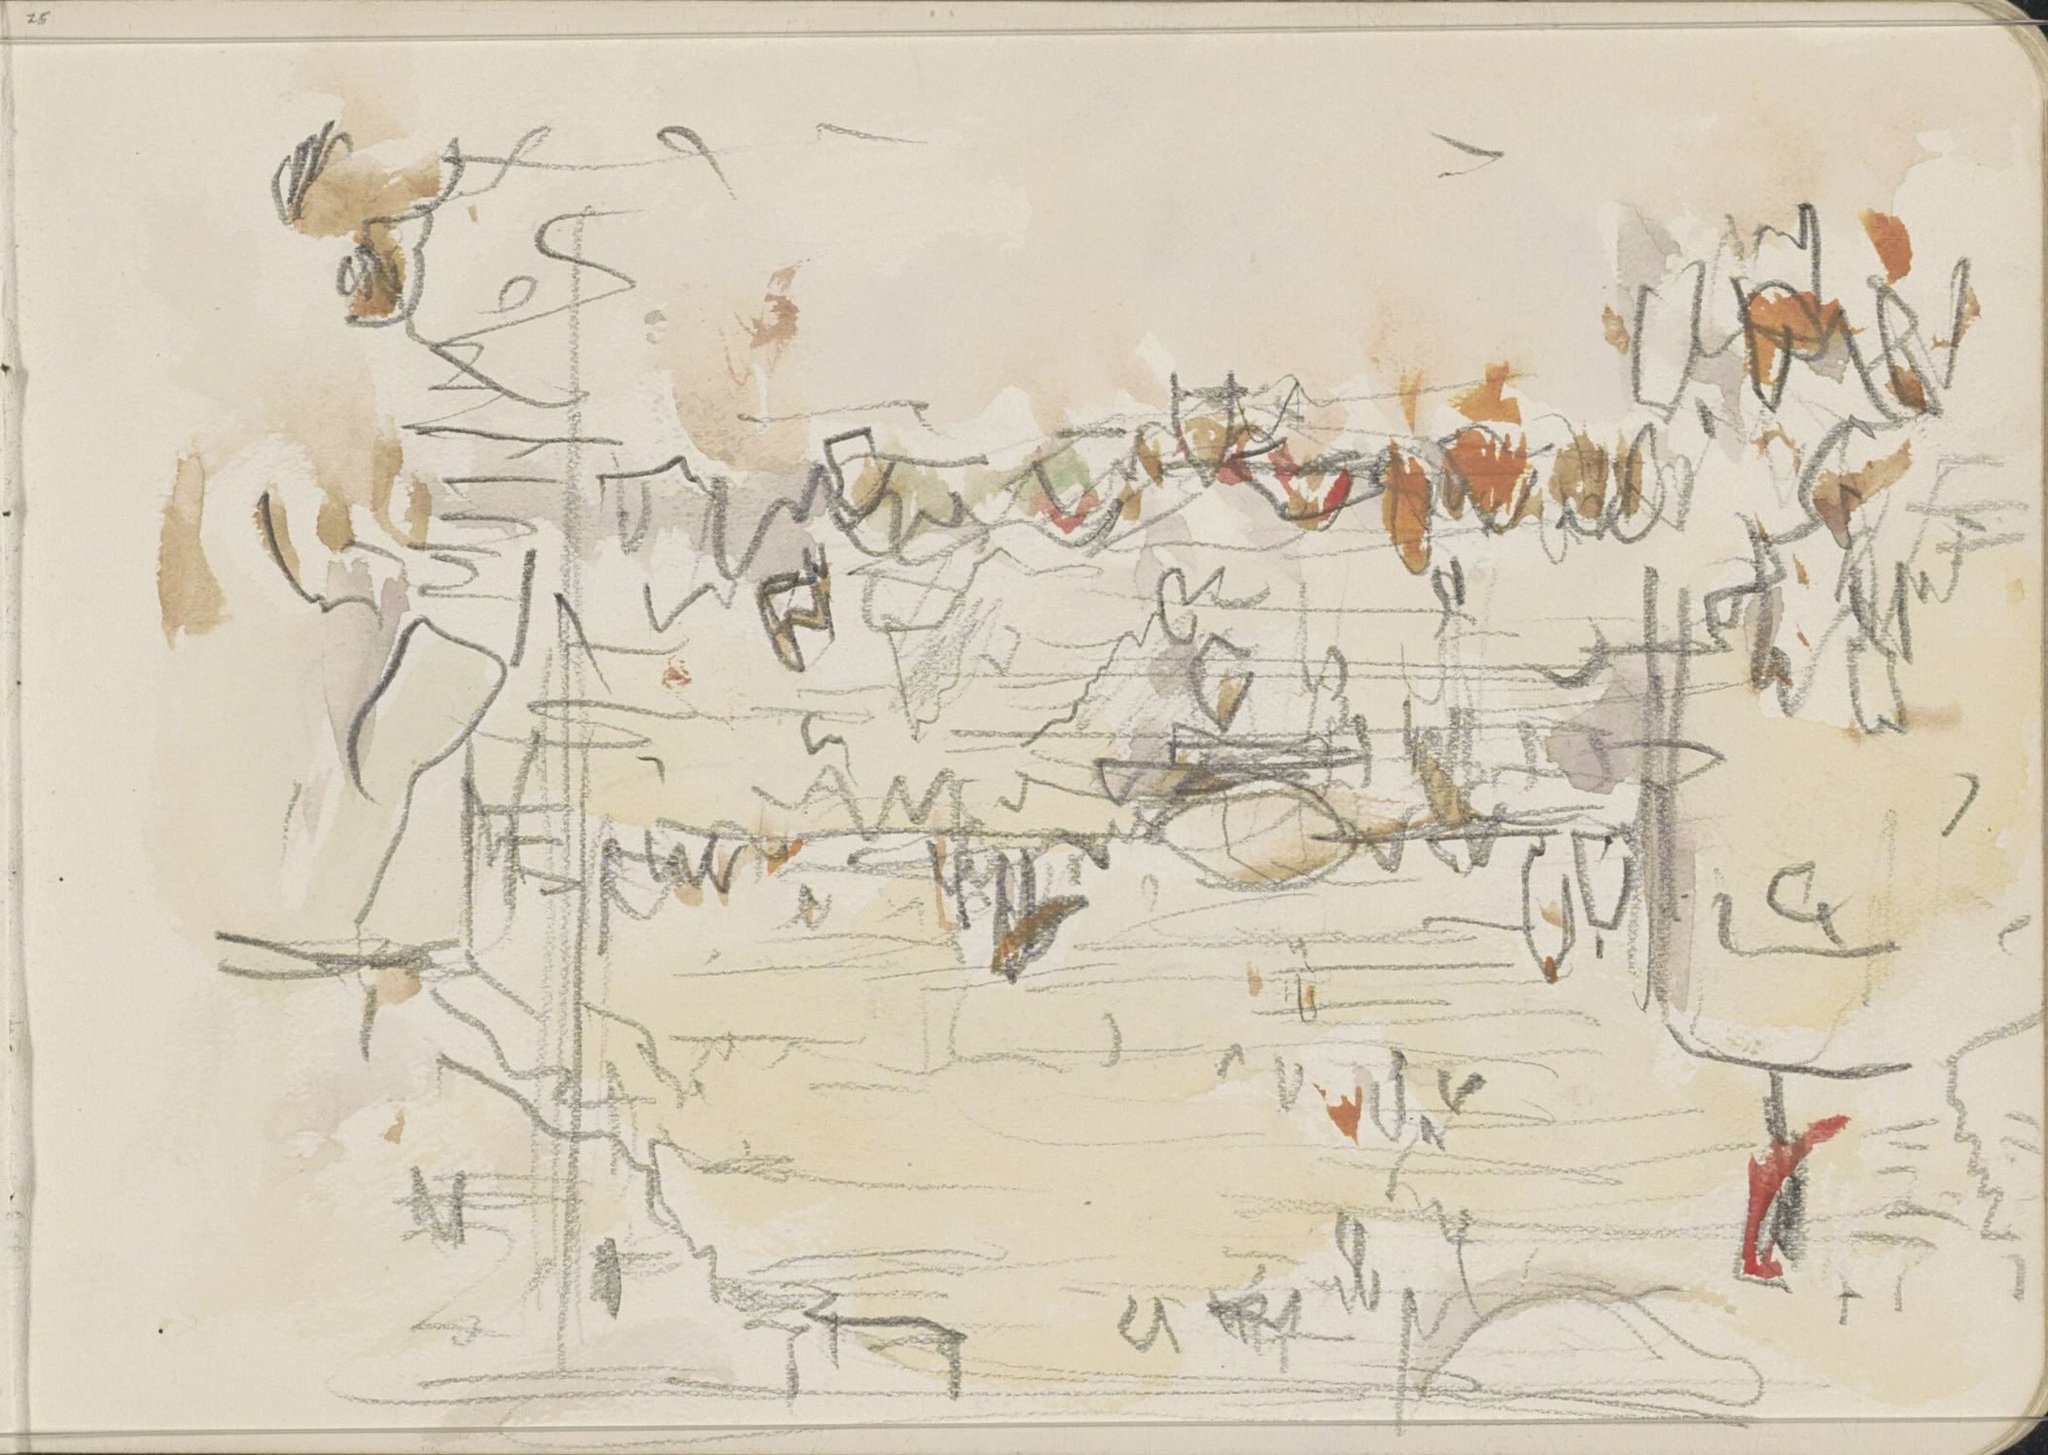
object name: sketchbook leaf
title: Indiërs badend in de Ganges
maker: marius bauer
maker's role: draughtsman, print maker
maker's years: 1867-1932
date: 1924-1925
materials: paper, pencil, watercolor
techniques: brush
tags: flight of steps, river, bathing (movement in water), asiatic races and peoples: indians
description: Op de achtergrond de trap die naar de rivier leidt. Pagina 25 uit een schetsboek met 23 bladen.